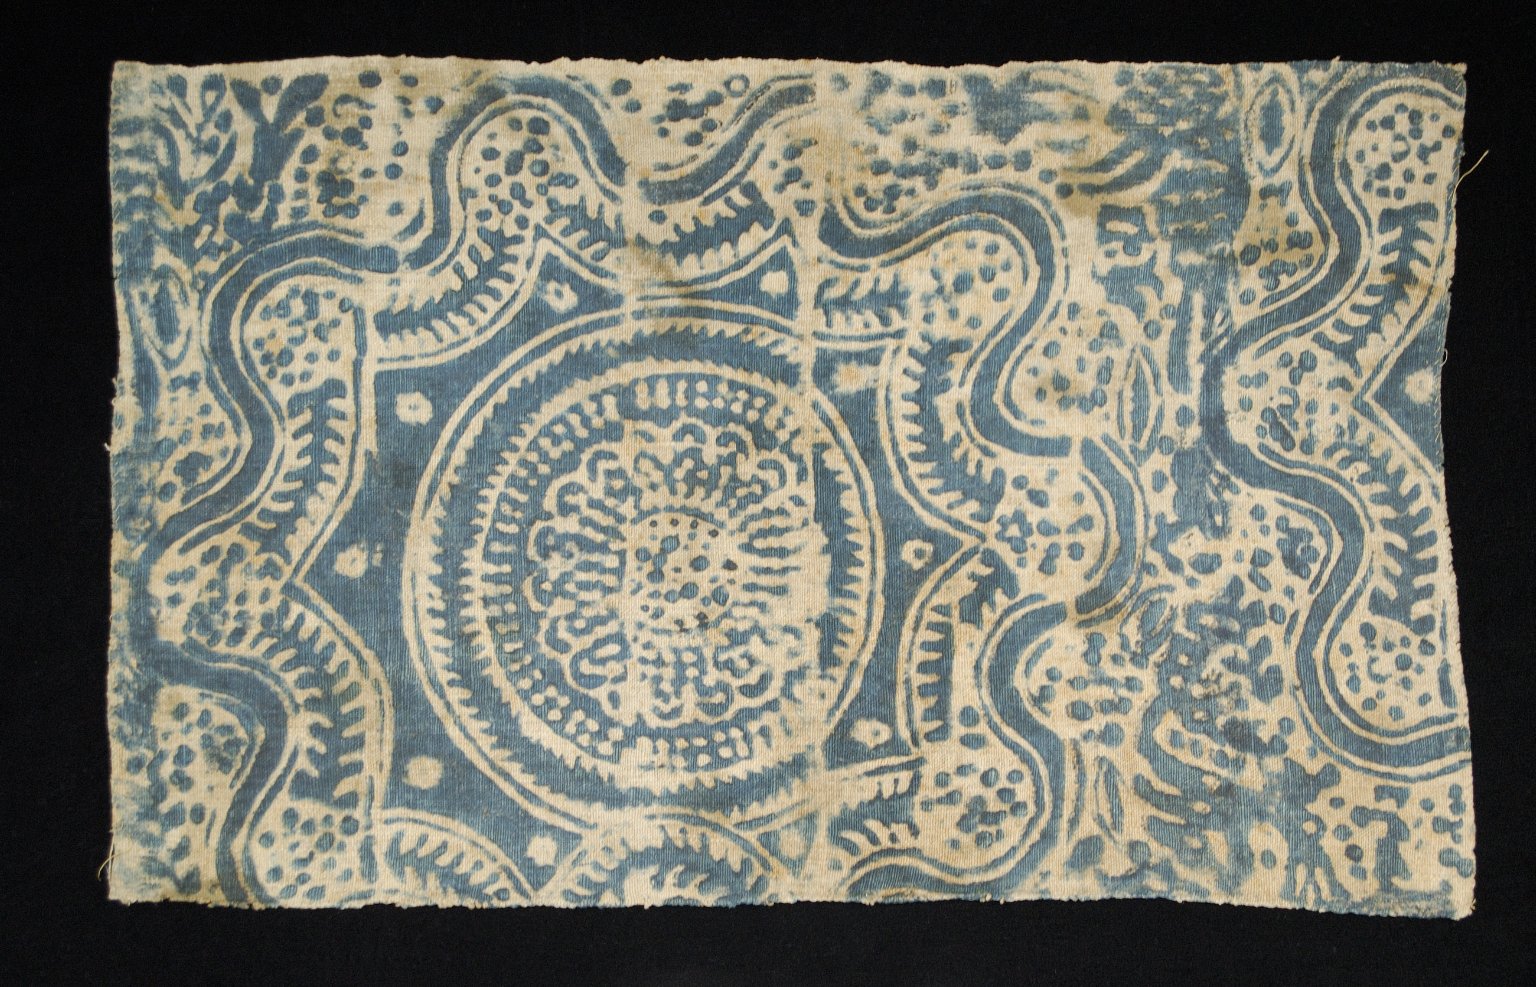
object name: fragment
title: Textile fragment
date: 1700-1899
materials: linen